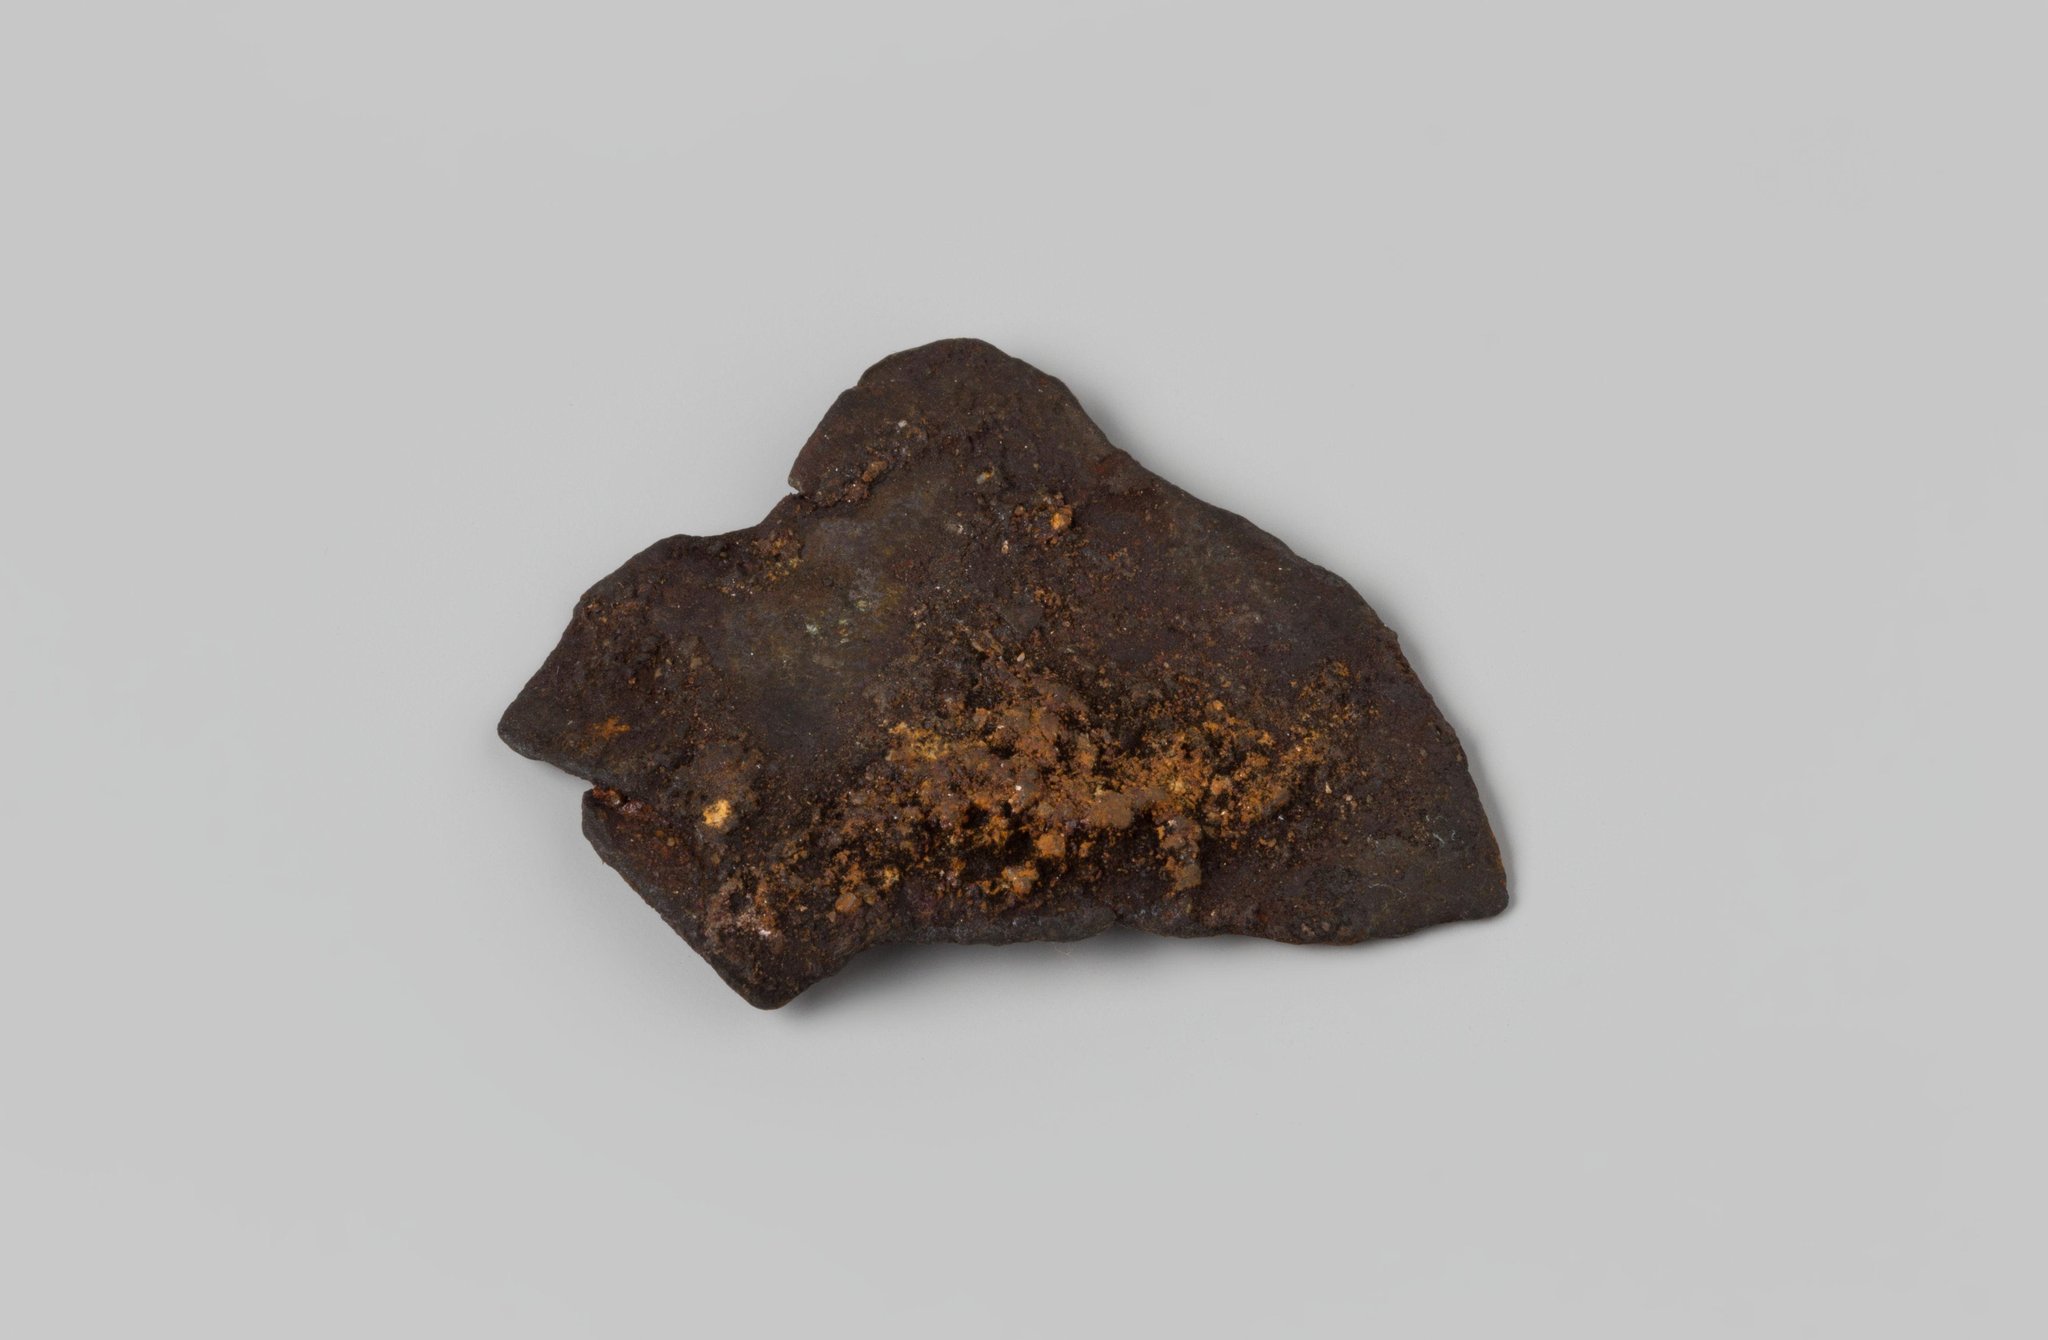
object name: scheepswrakvondst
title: Fragment van koper uit het wrak van de Oost-Indiëvaarder Hollandia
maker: Anonymous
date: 1700-1743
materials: copper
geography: netherlands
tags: verenigde oostindische compagnie, hollandia (schip), annet